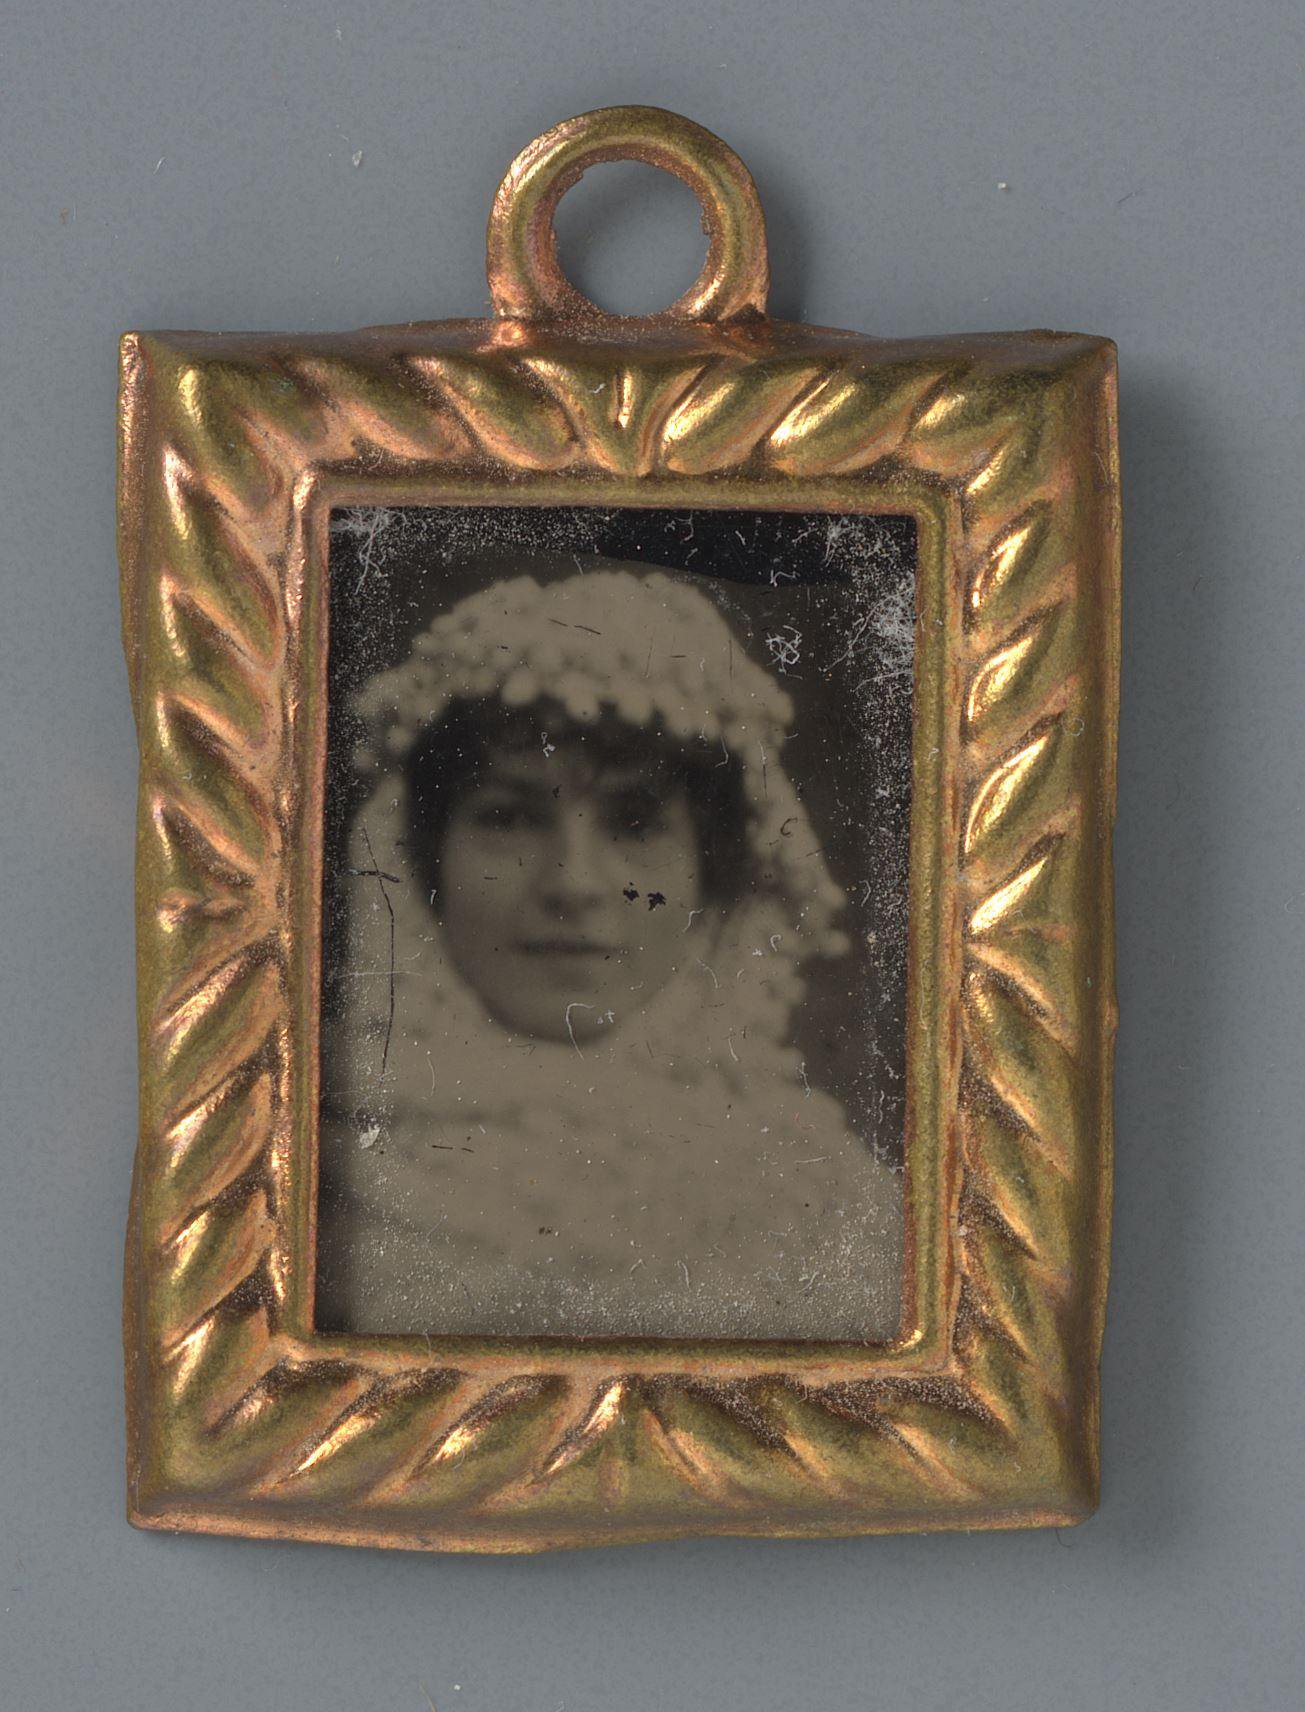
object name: photograph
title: Miniatuurportret van een onbekende vrouw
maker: Anonymous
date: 1855-1940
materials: iron, metal, paper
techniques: ferrotyping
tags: historical persons - bb - woman